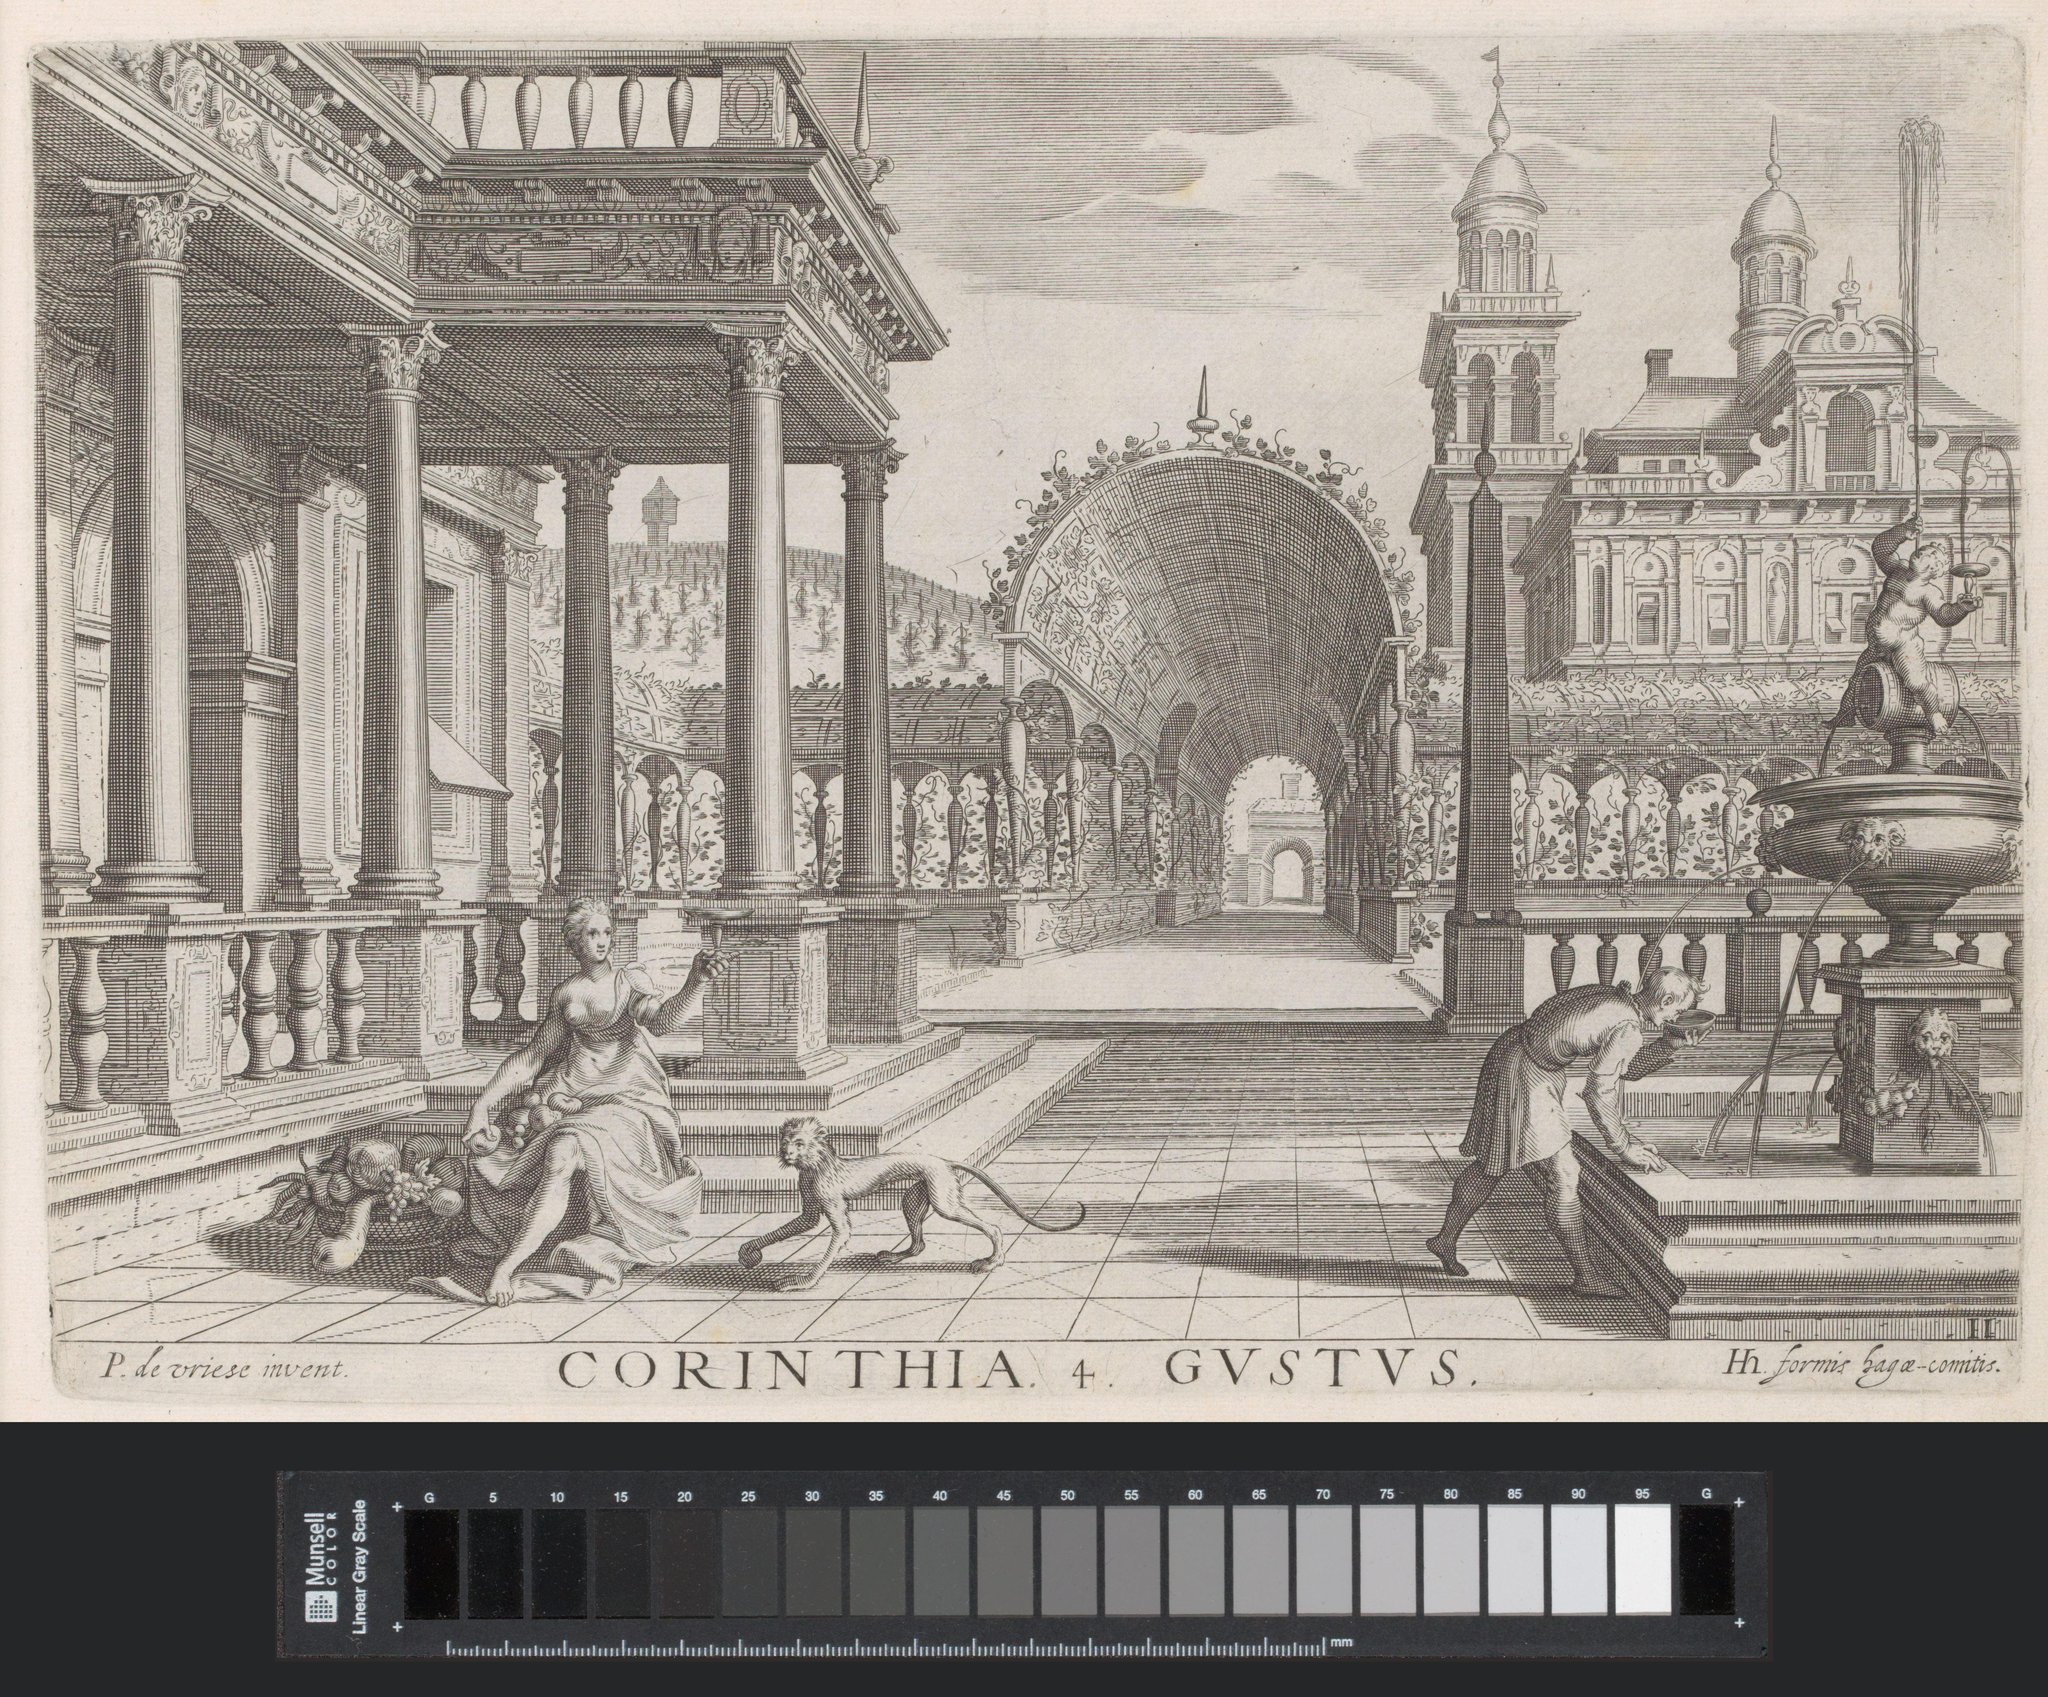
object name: album leaf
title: Portaal van een gebouw met Korinthische zuilen en het zintuig smaak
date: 1606-1607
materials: paper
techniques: engraving, etching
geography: amsterdam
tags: taste, tasting (one of the five senses), corinthian order ~ architecture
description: Links het portaal van een gebouw met Korinthische zuilen. Op de voorgrond een vrouw die naast een mand met vruchten zit en een tassa in haar hand houdt. Zij verbeeldt het zintuig smaak. Op de achtergrond een gang van traliewerk. Rechts een fontein. Rechtsonder: II. Prent maakt deel uit van een album.